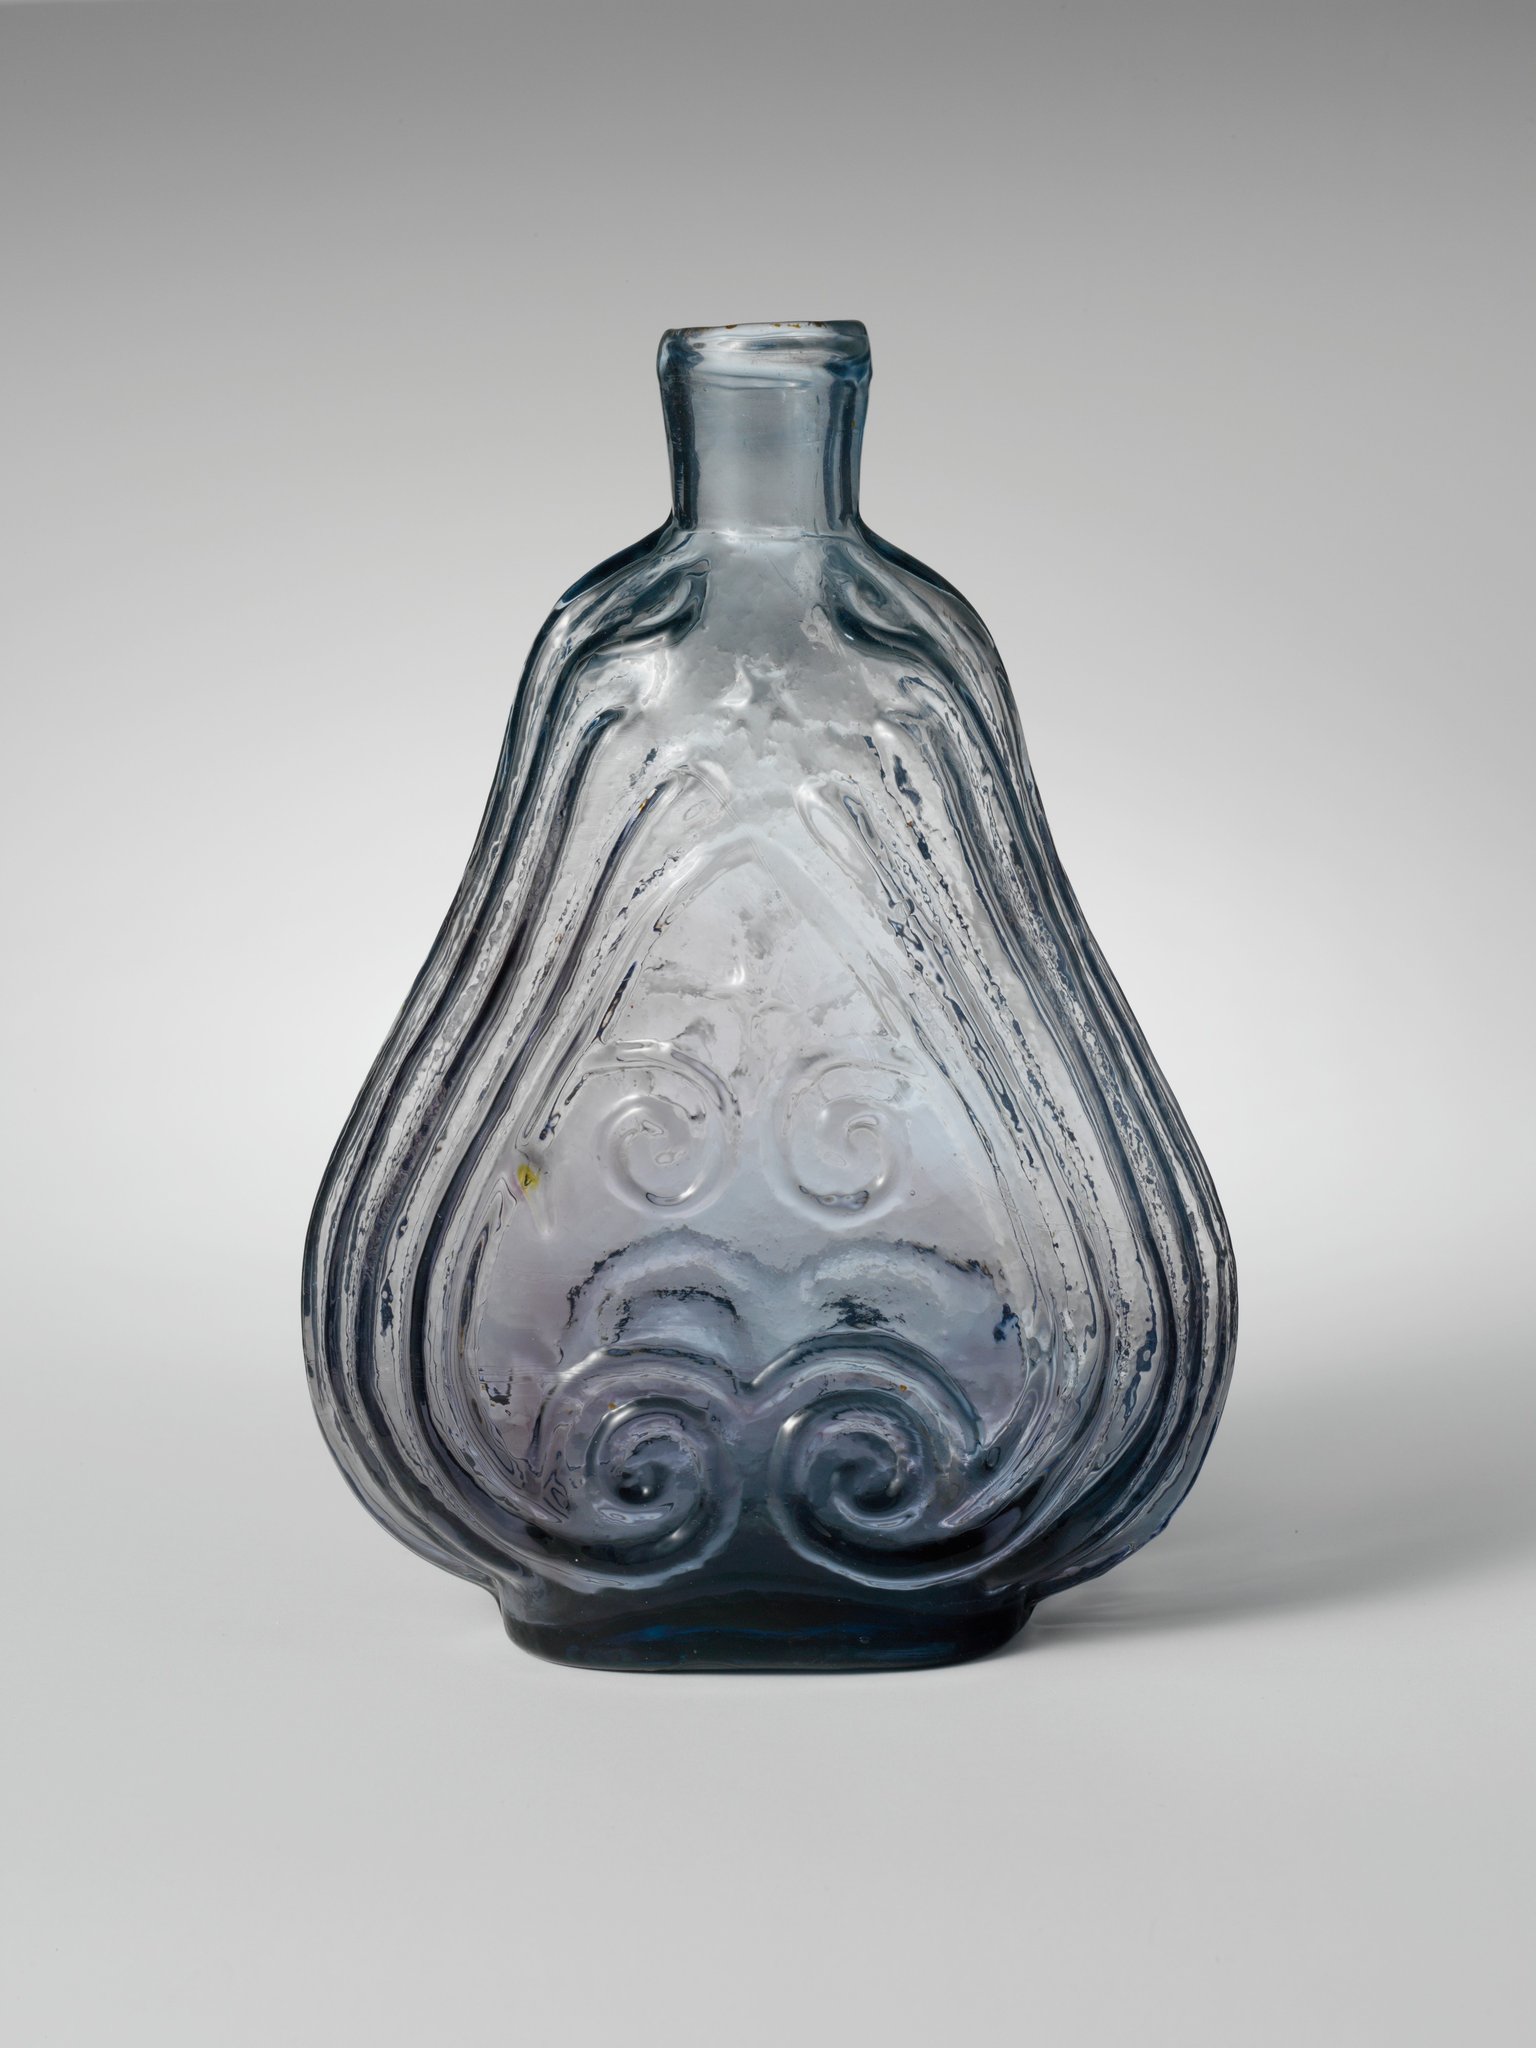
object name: flask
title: Scroll flask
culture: american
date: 1840-1850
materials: glass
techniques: glassblowing, molding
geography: united states